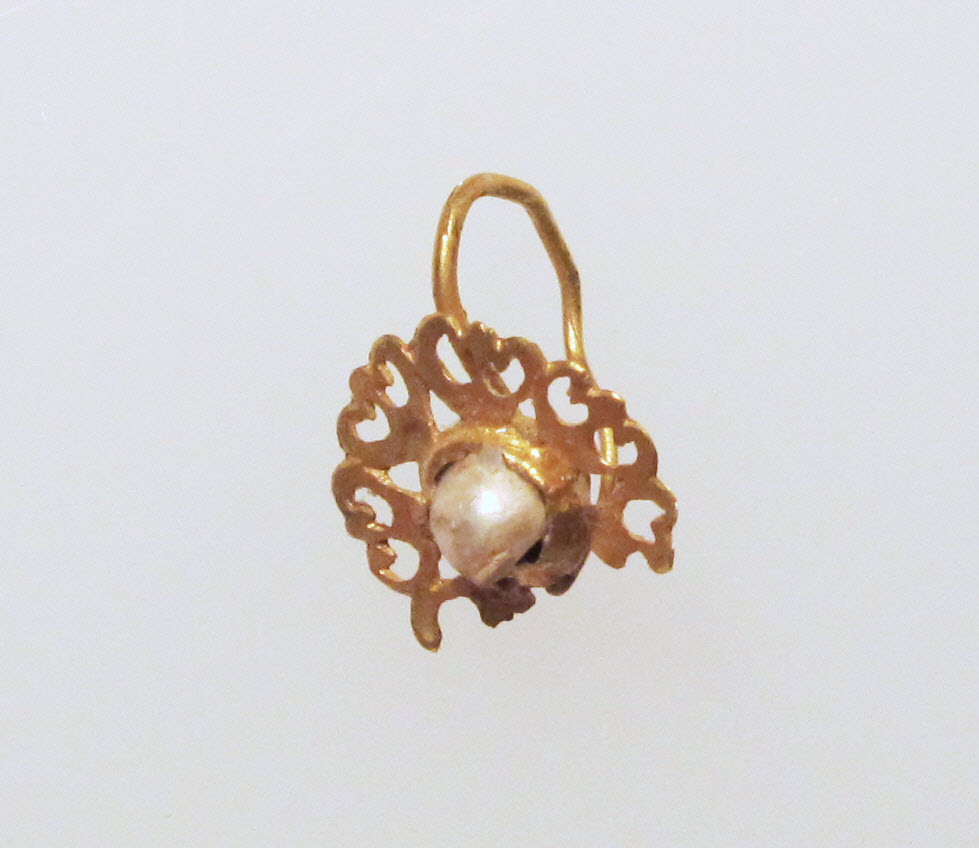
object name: earring with disc and pearl setting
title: Gold earring with pelta disc and pearl setting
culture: roman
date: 201-300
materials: gold, pearl